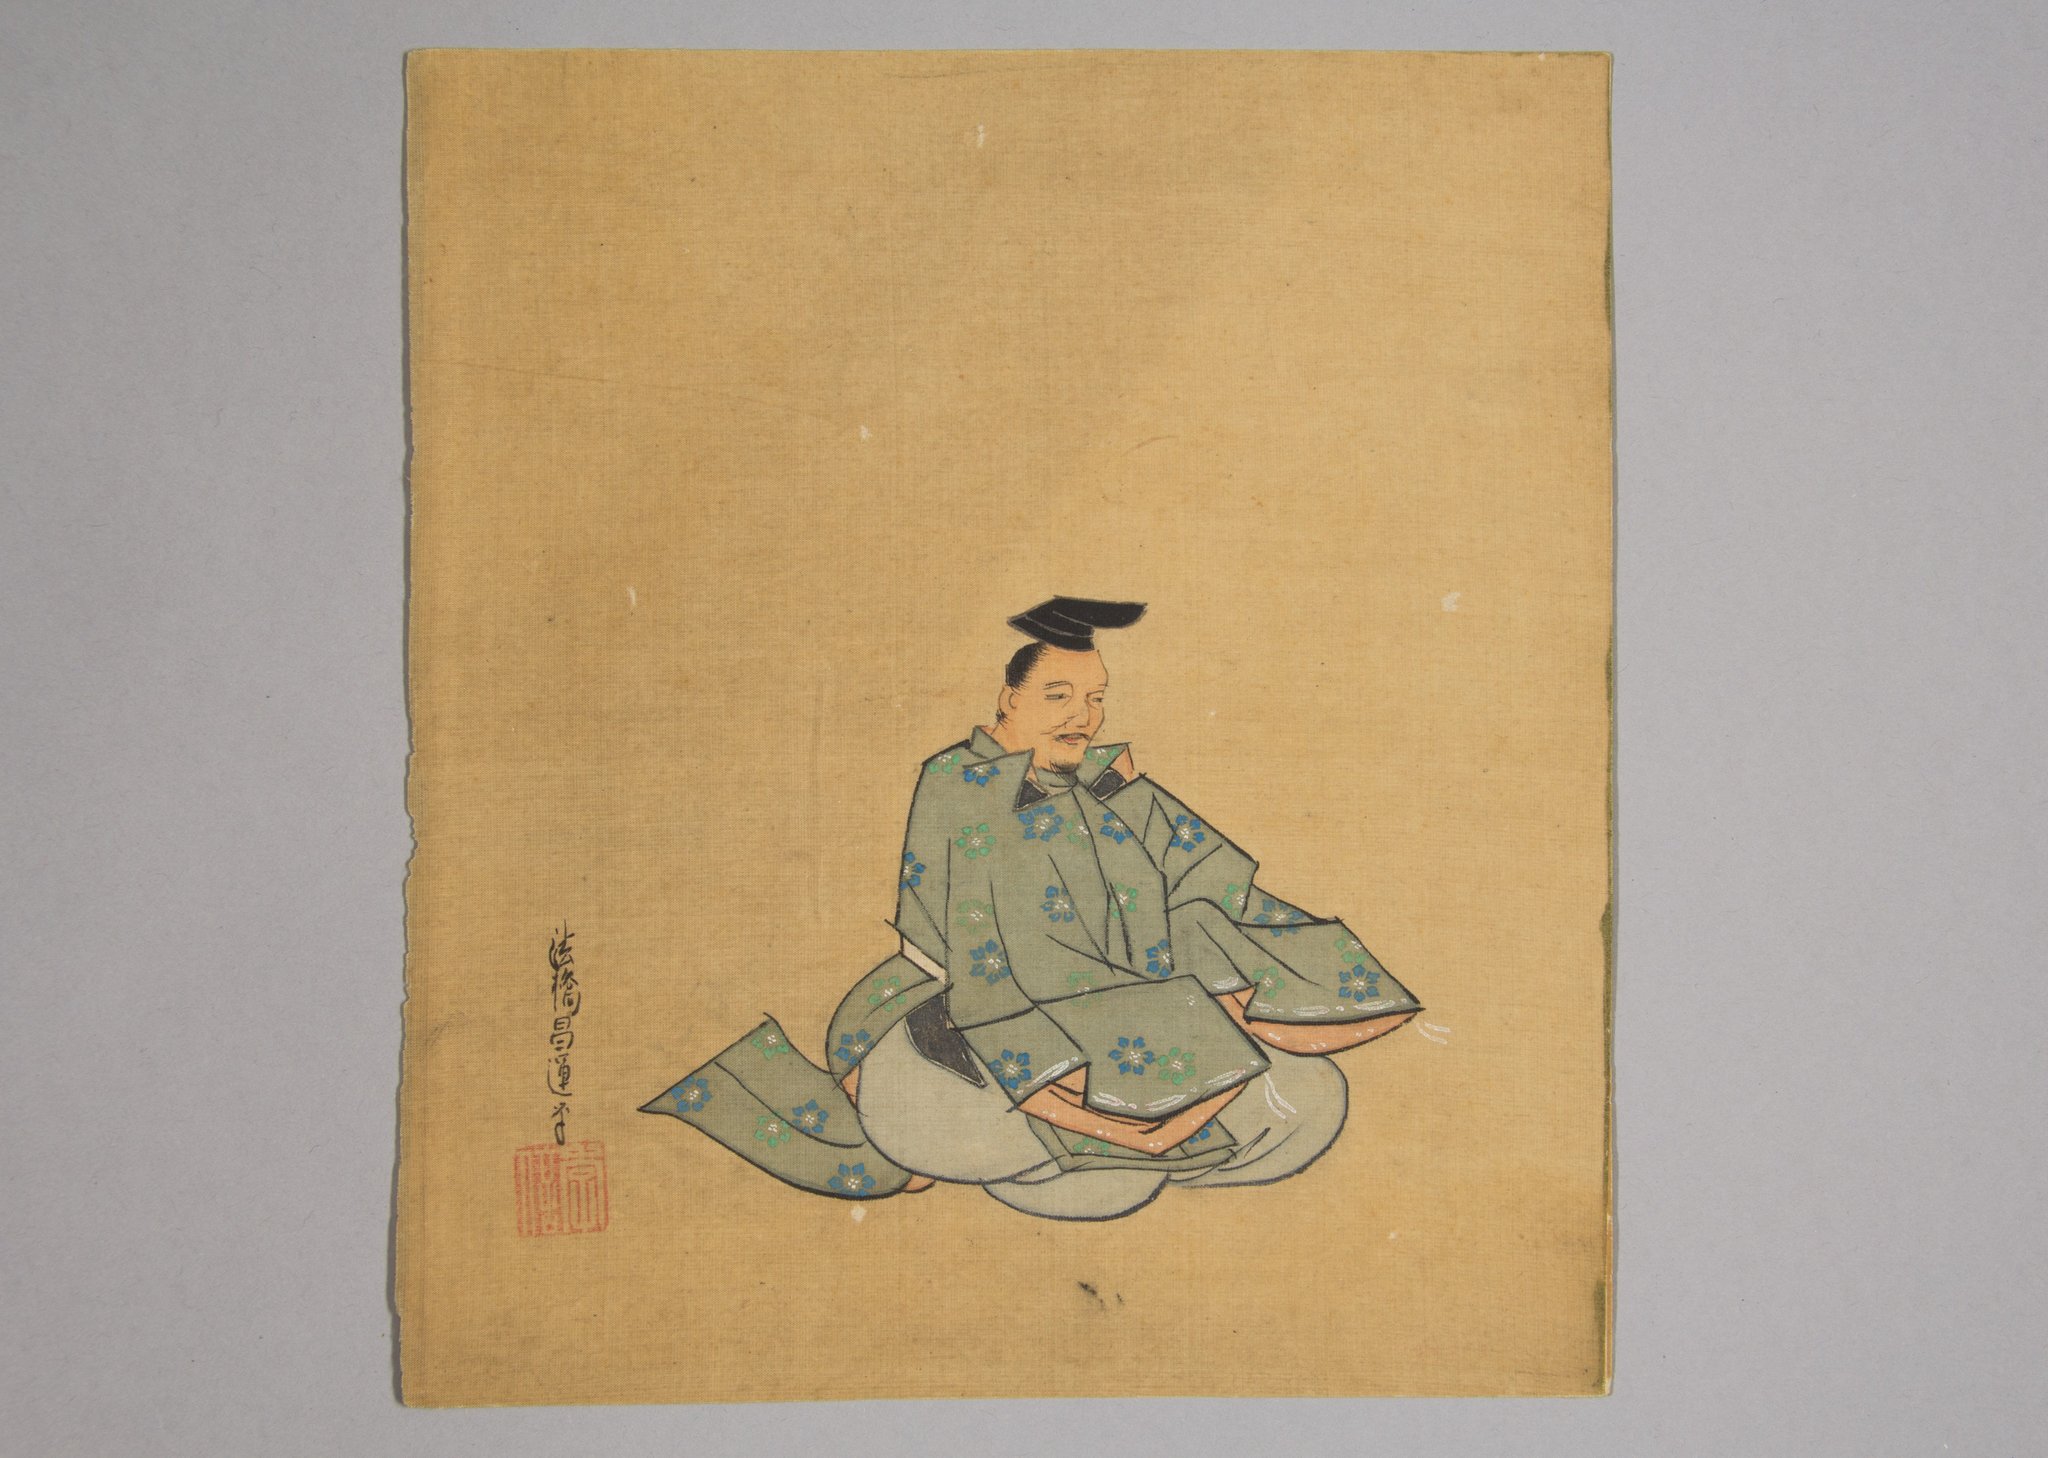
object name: painting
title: Immortal Poet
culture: japanese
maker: kano shōun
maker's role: artist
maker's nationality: japanese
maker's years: 1637-1702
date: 1601-1700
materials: ink, silk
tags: men,poets